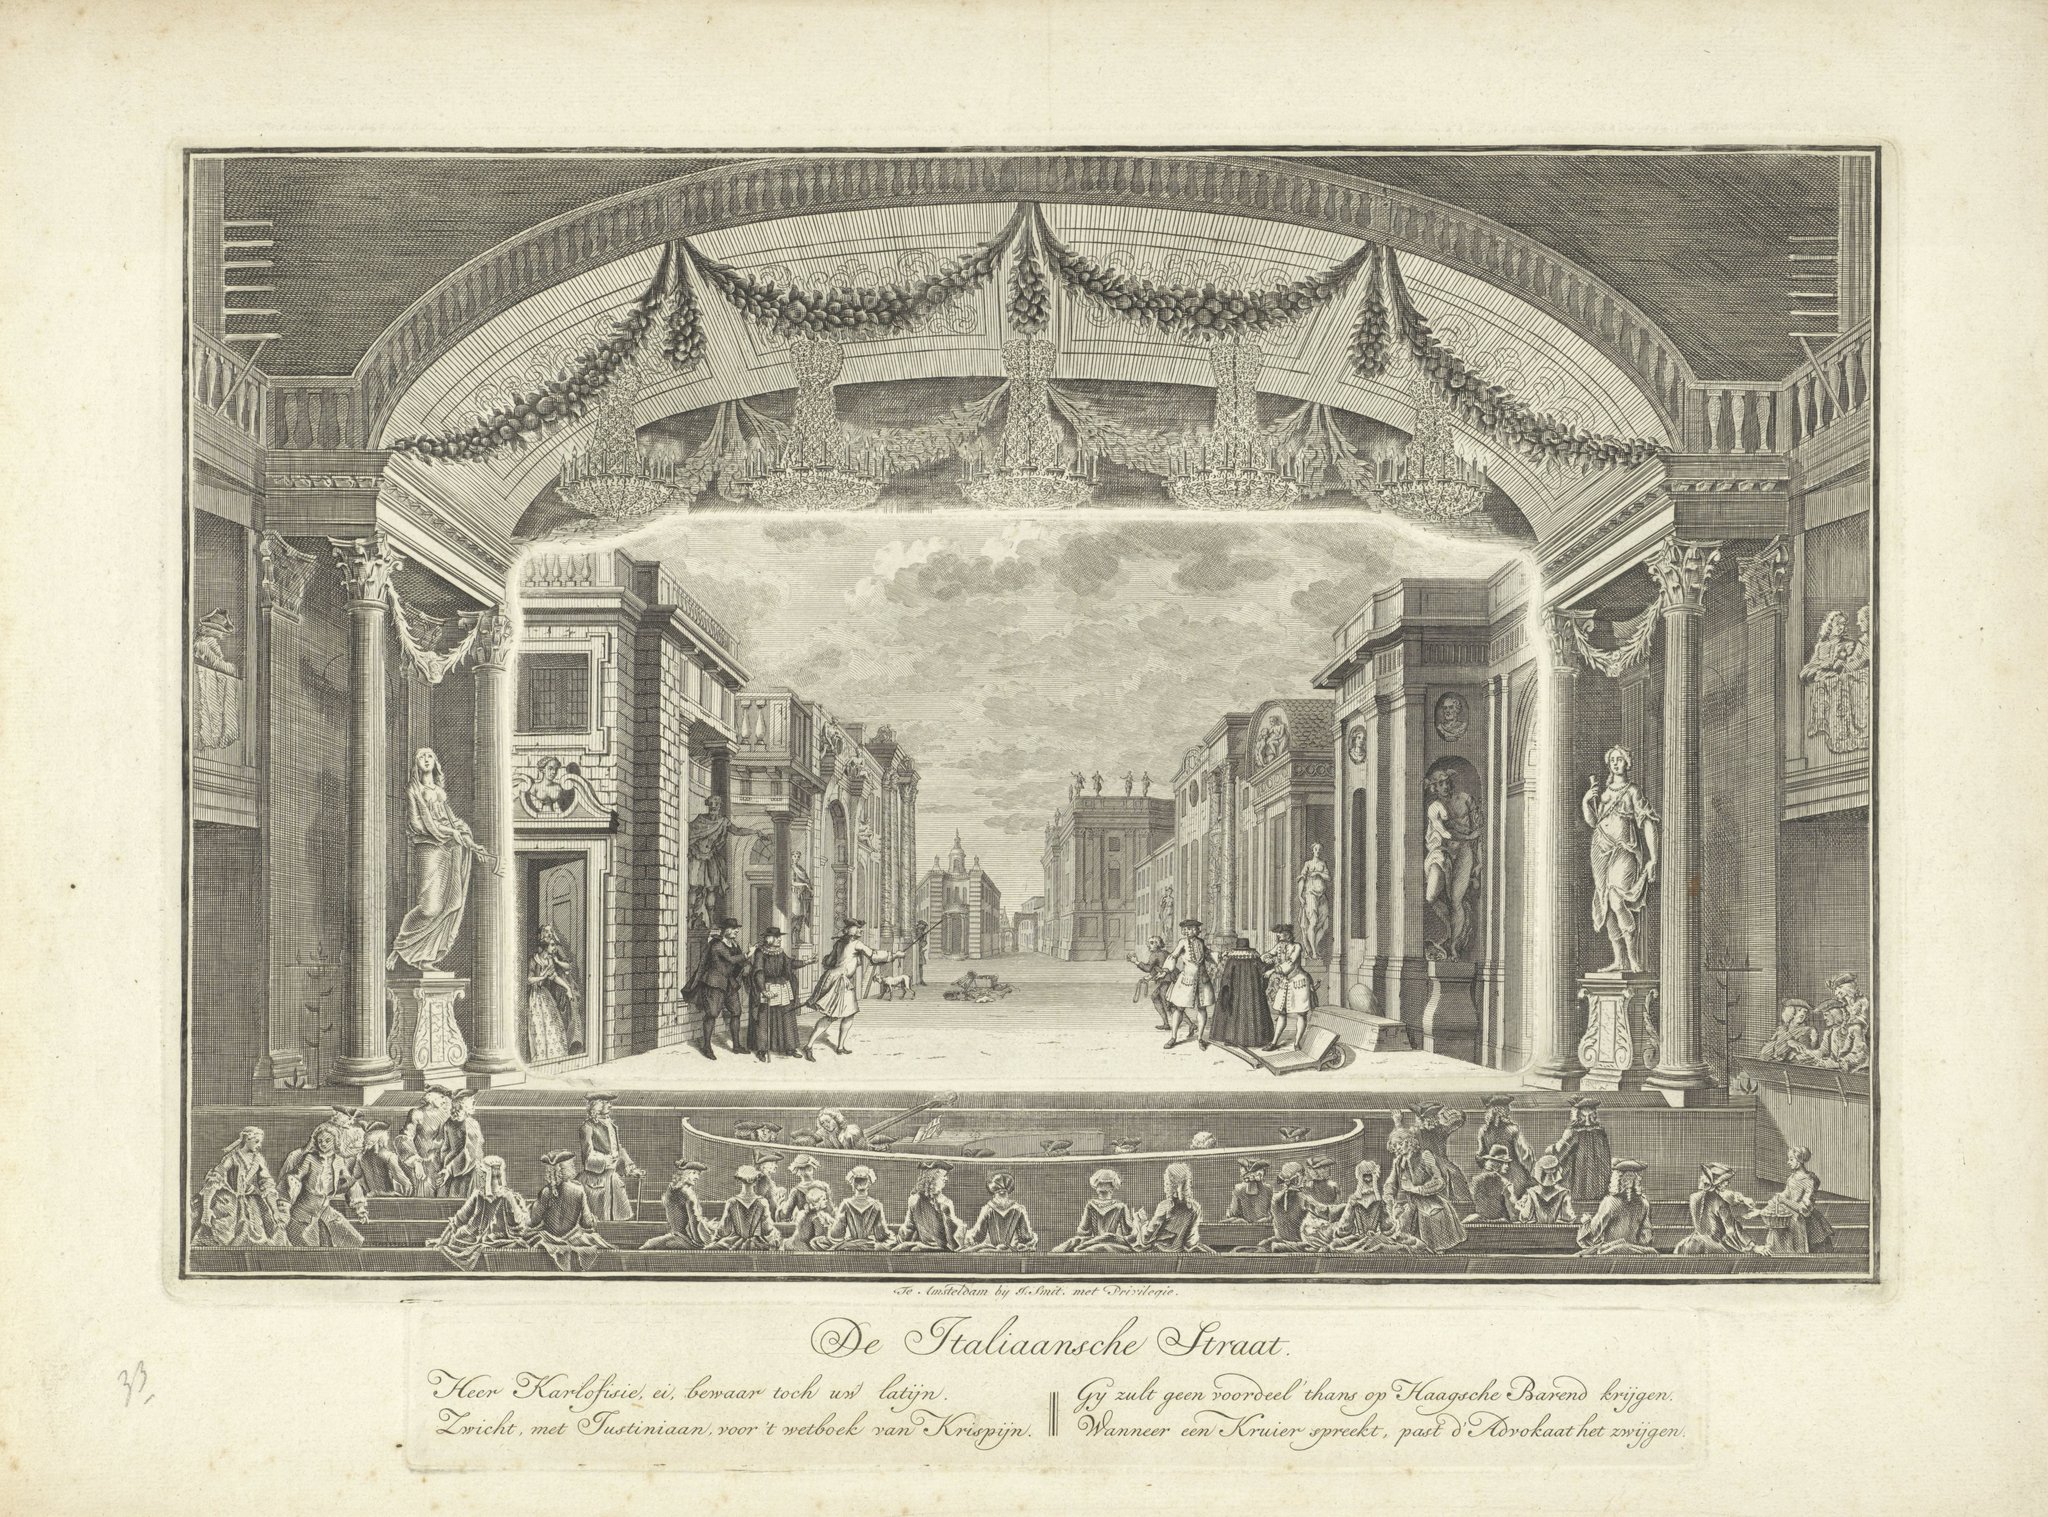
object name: print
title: Schouwburg met toneeldecor: De Italiaansche Straat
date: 1736-1738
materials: paper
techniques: engraving, etching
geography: amsterdam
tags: theatre, theatrical performance, stage design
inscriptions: caption: ‘Heer Karlofisie, ei, bewaar toch uw latijn.. Wanneer een kruier spreekt, past d'Advokaat het zwijgen.’, title: ‘De Ialiaansche Straat.’, collector's mark: Lugt 2228, address: ‘te Amsterdam, by J. Smit, met Privilegie. Met 2 x 2 regels onderschrift:’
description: Toneelvoorstelling in de Amsterdamse Schouwburg op de Keizersgracht met het coulissendecor De Italiaansche Straat met scène uit: De Gewaande Advocaat. Het decor gedrukt van een aparte plaat binnen een passe-partout met de zaal, zijloges, orkestbak en de façade van het toneel met zuilen, guirlandes en kroonluchters. De titel en een vierregelig vers ook gedrukt van een aparte plaat. Onderdeel van een serie van twaalf toneeldecors.